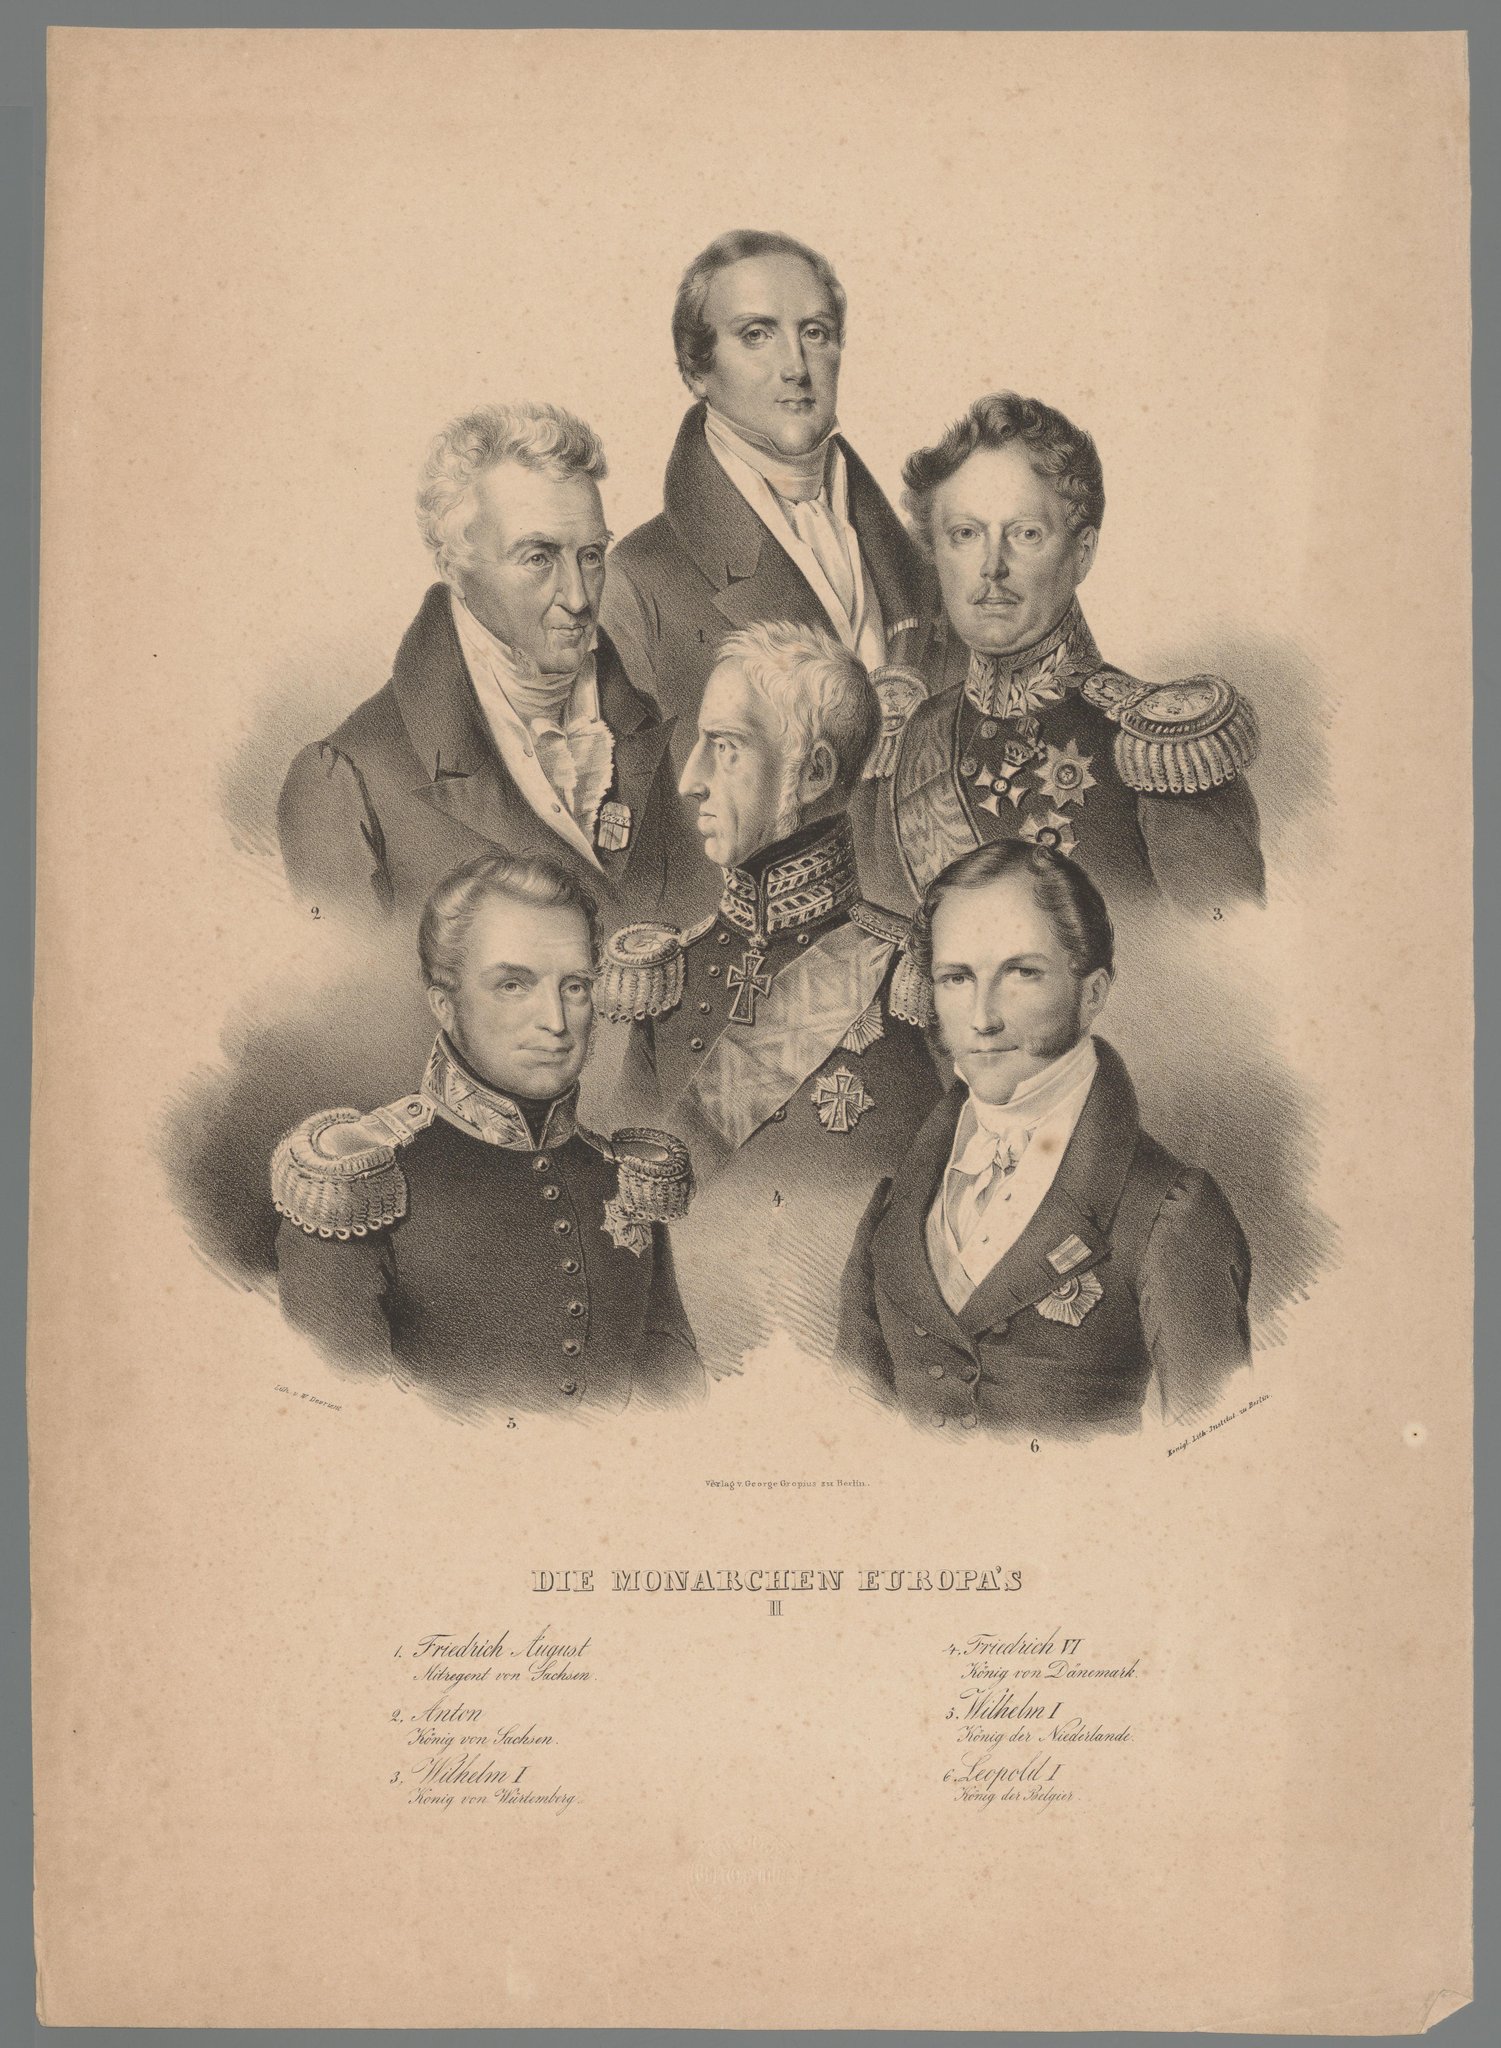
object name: print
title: Portretten van zes Europese vorsten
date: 1809-1836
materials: paper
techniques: lithograph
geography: berlin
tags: willem i koning van württemberg, the hague, berlin, william i of the netherlands, leopold i (koning der belgen), historical persons, king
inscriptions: collector's mark: Lugt 2228, check stamp: Lugt 4221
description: Portretten van Frederik August II van Saksen, Anton (koning van Saksen), Willem I (koning van Württemberg), Friedrich VI (koning van Denemarken), Willem I (koning der Nederlanden) en Leopold I (koning der Belgen).